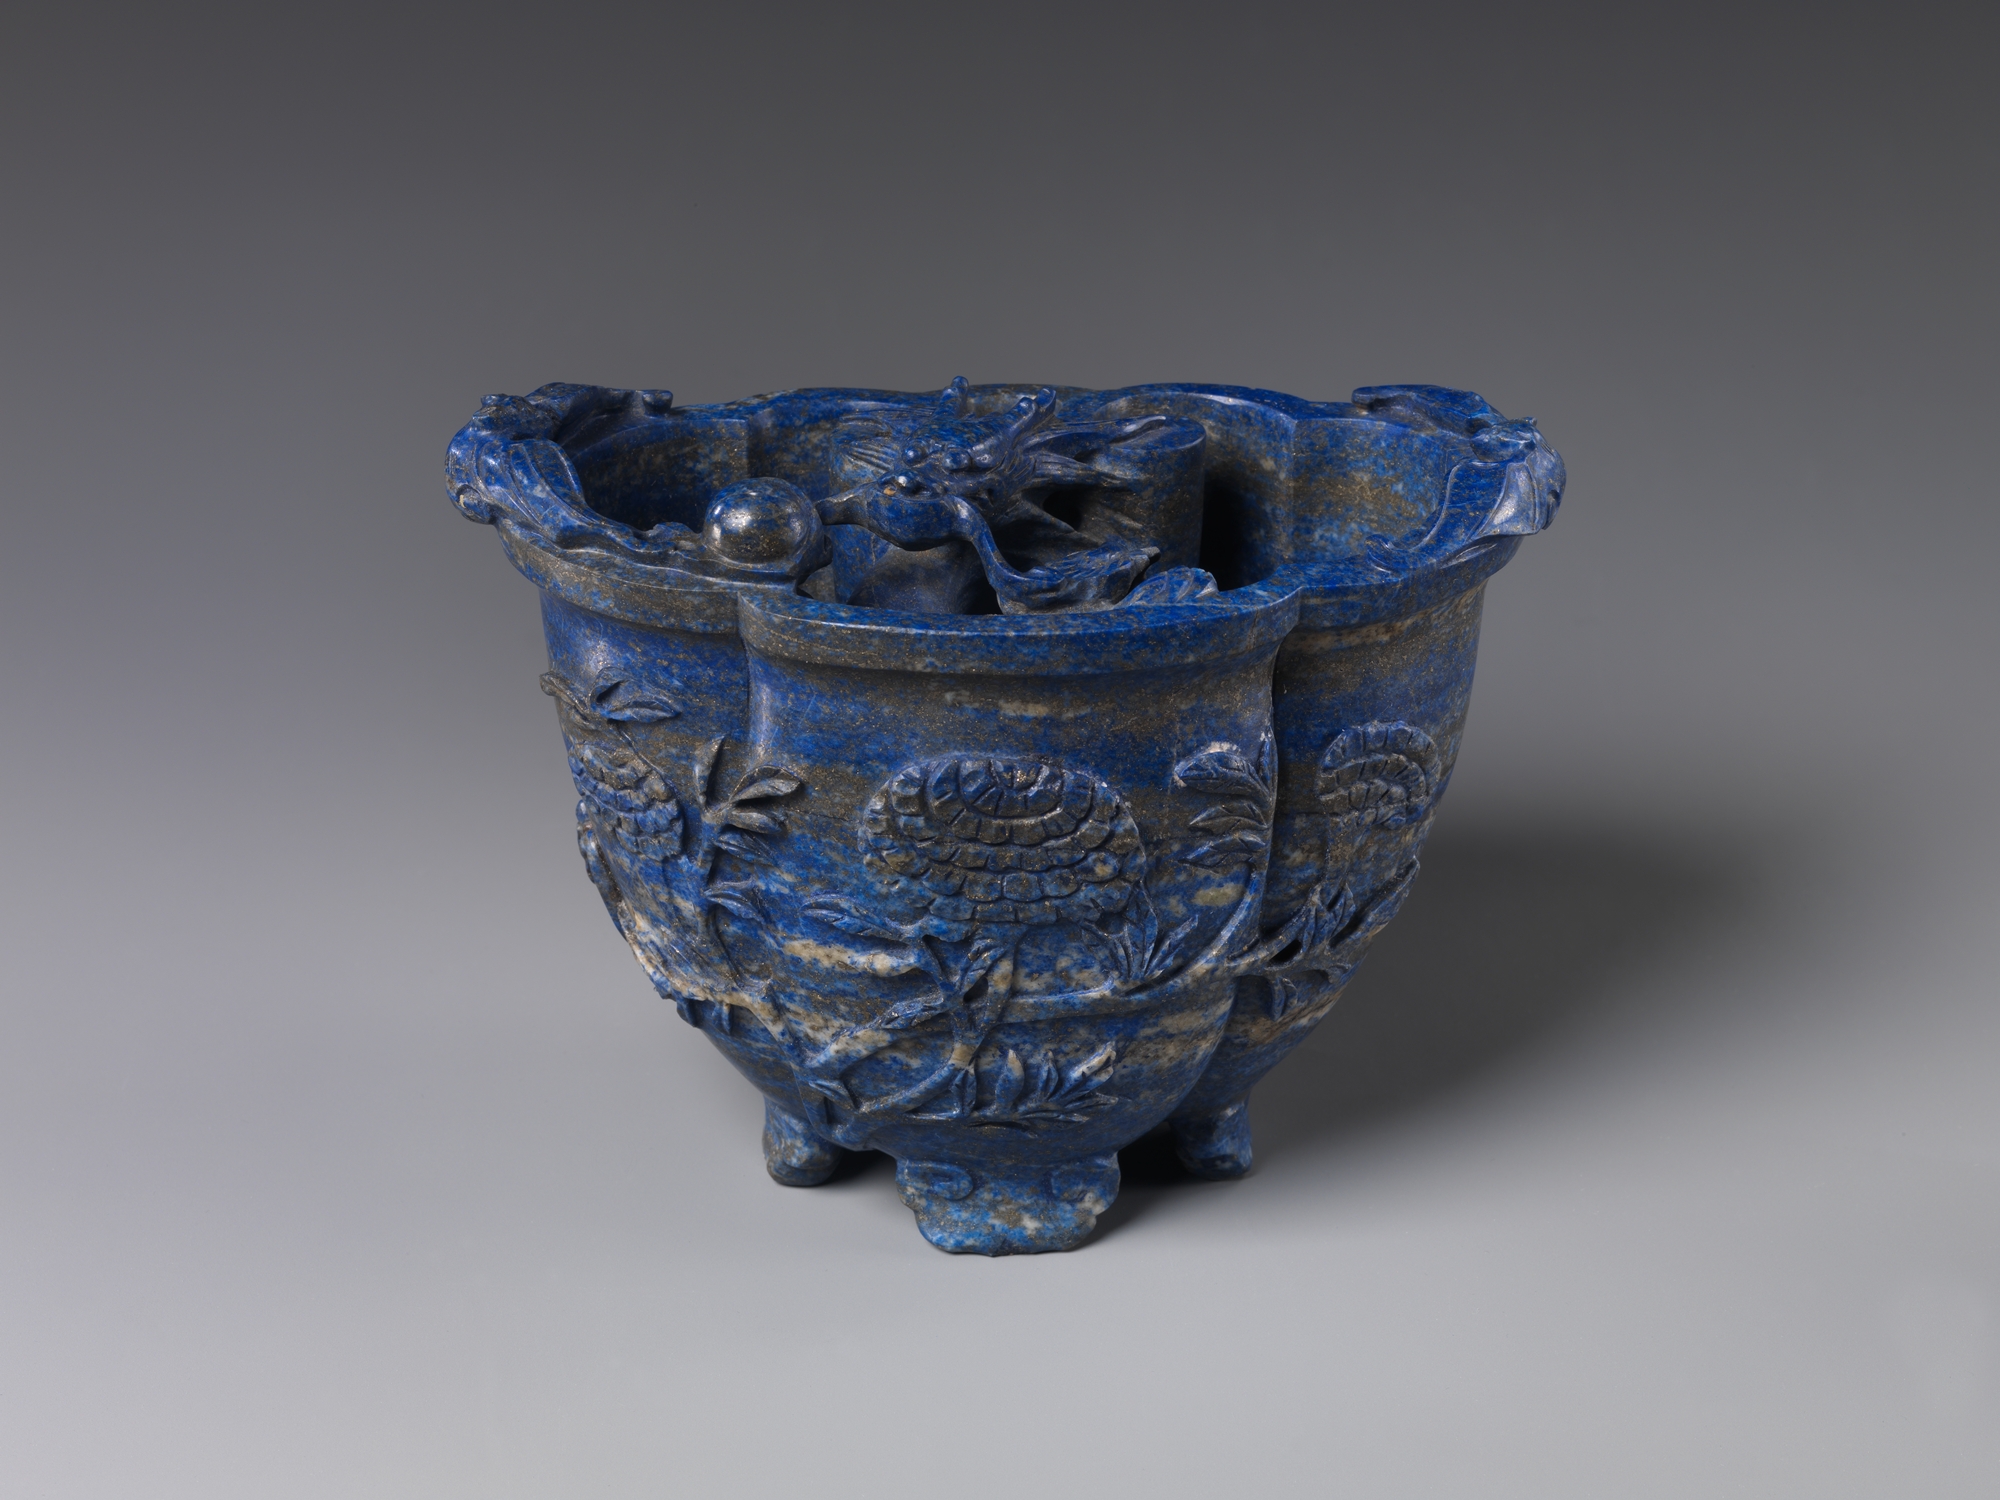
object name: bowl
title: Tripod with dragon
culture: chinese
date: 1701-1800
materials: lapis lazuli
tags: dragons,plants